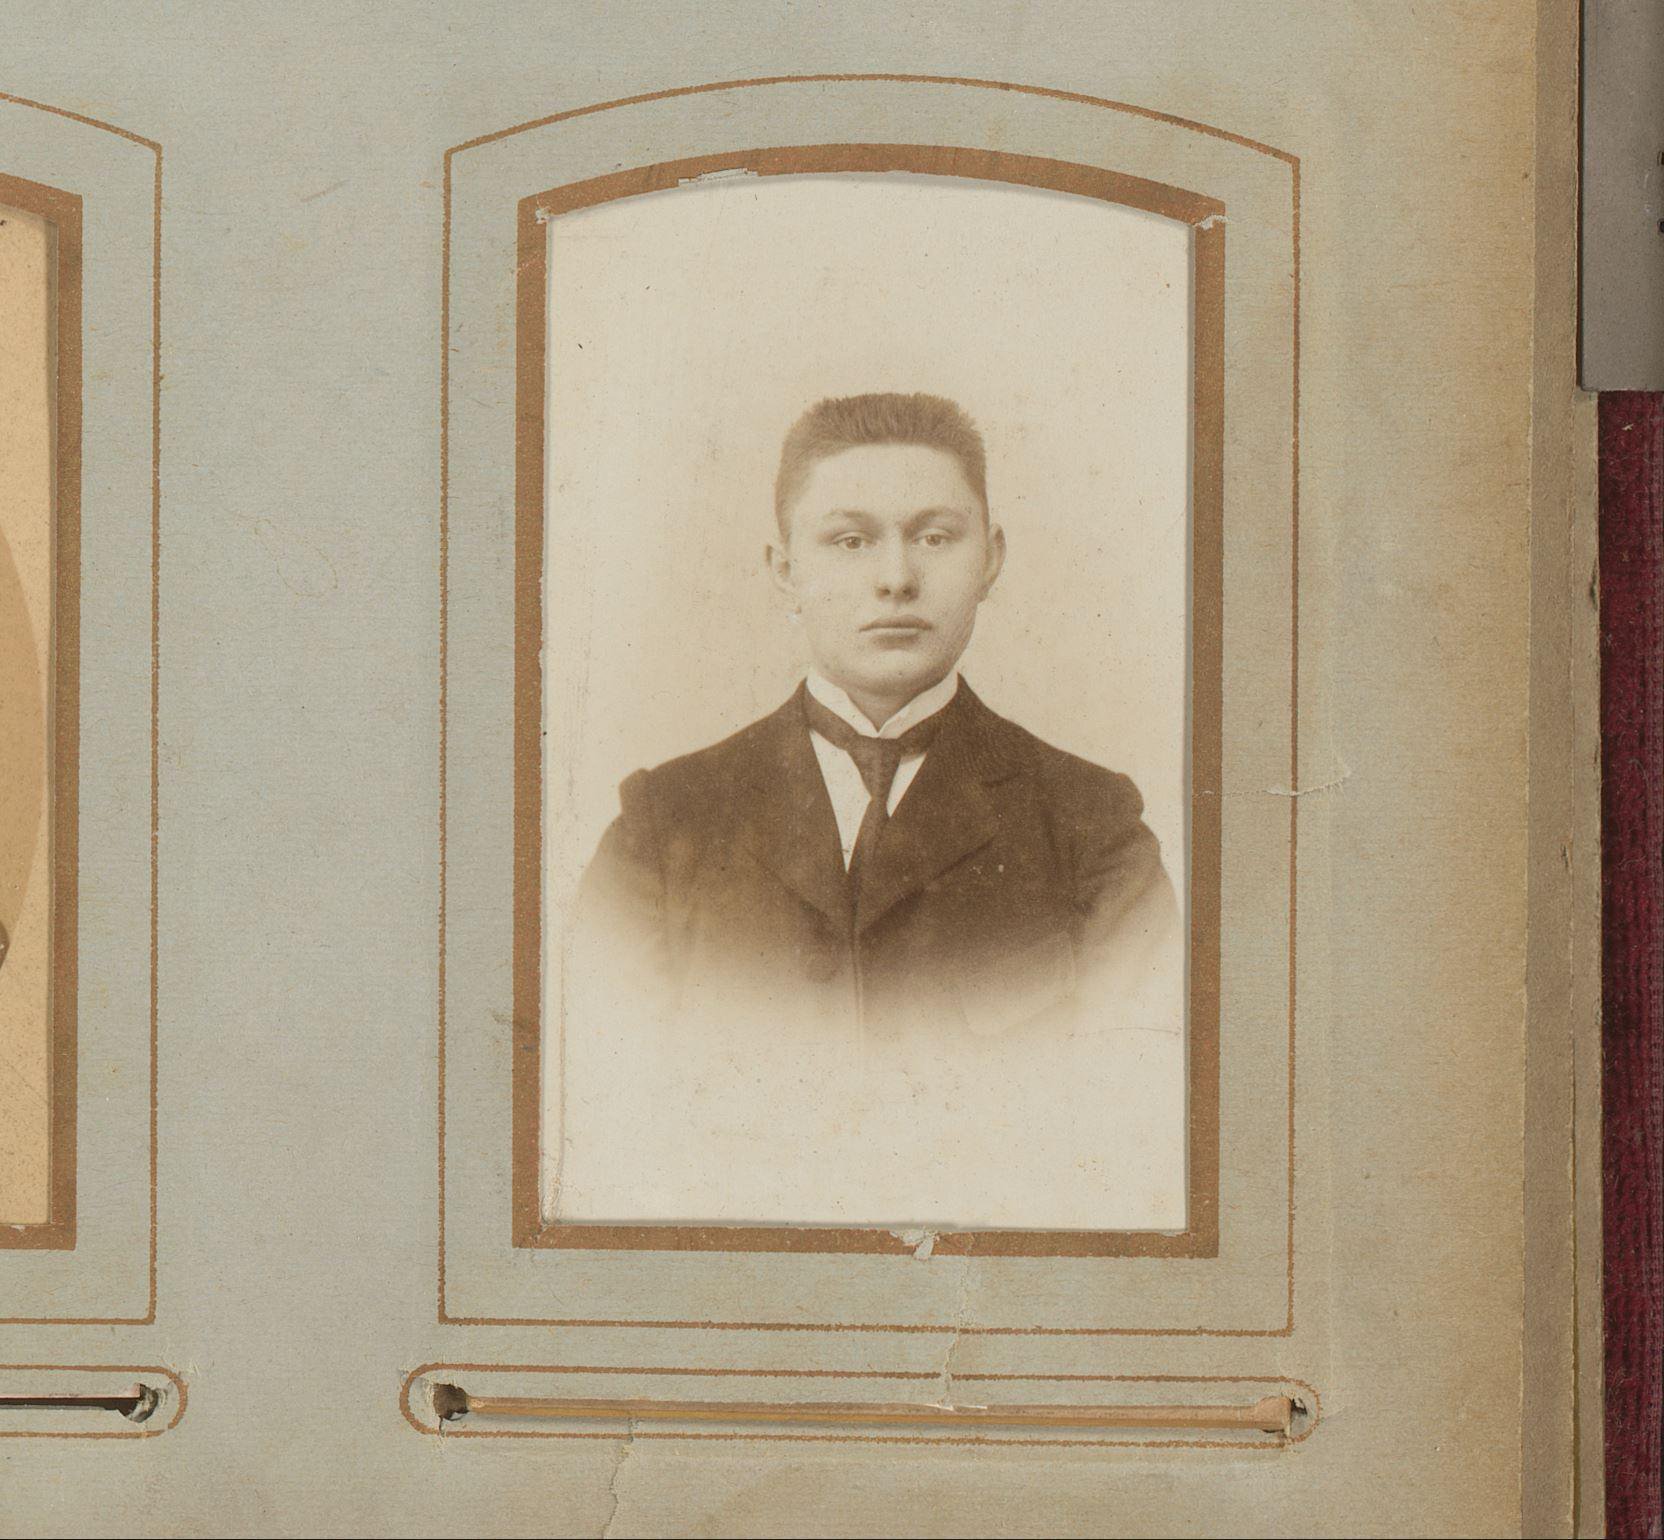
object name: album leaf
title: Portret van een jongeman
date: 1880-1920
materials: cardboard, photographic support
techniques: collodion silver print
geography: amsterdam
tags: youth, adolescent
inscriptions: inscription: ‘Photographie/ Artistique/ Rembrandt/ Amsterdam/ Rembrandtplein 60’, number: ‘No. 2846’